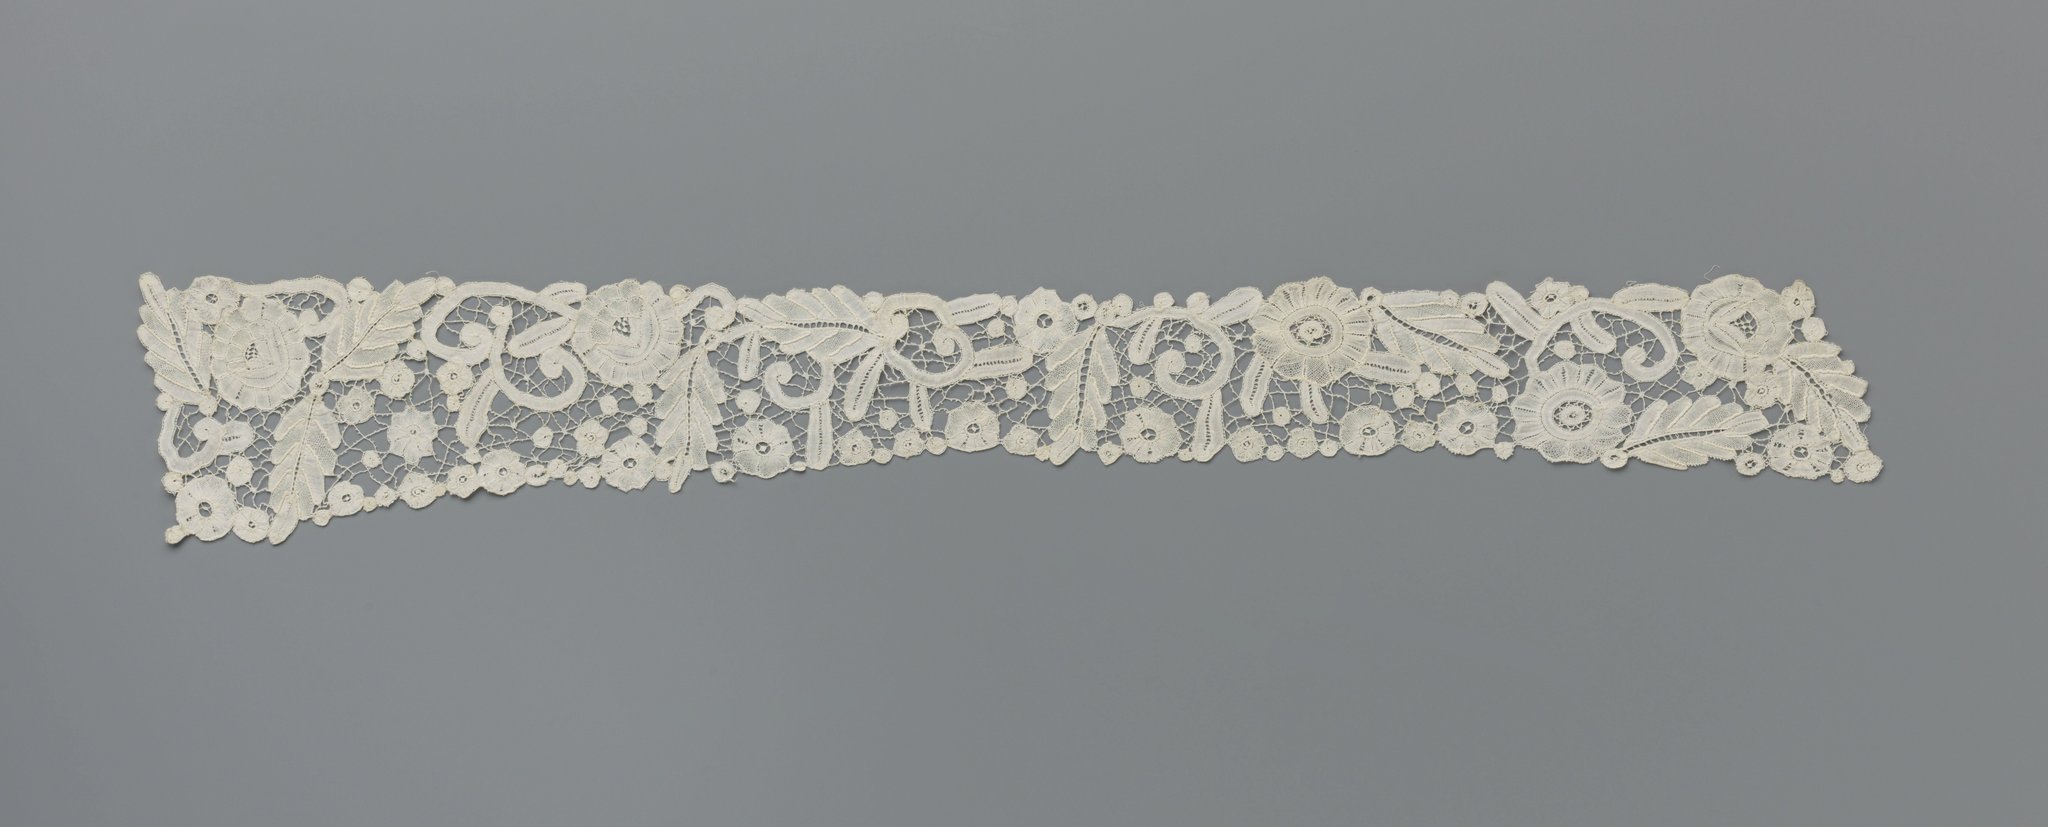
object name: sierstuk, sierobject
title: Sierstuk voor een avondmantel van gemengde kant met rozenhaag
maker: martha berkers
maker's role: kantwerkster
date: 1915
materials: linen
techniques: lace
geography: sluis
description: Sierstuk voor een avondmantel van naturelkleurige gemengde kant - kloskant in combinatie met naaldkant - Brusselse duchesse. Op een wijd gespreide vlechtengrond staan rozen die meestal op twee bladeren steunen. Een tussenornament bestaat uit enkele en dubbele voluutranken en vele kleine bloempjes.